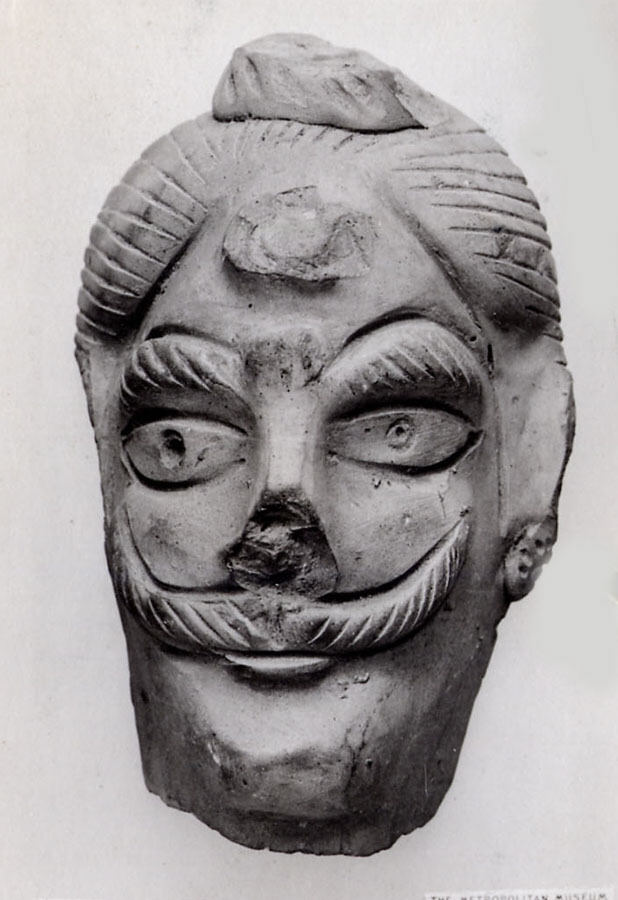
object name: relief fragment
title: Fragment of a Mask of a Man's Head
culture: central asian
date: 1101-1200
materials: terracotta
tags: masks,heads,men